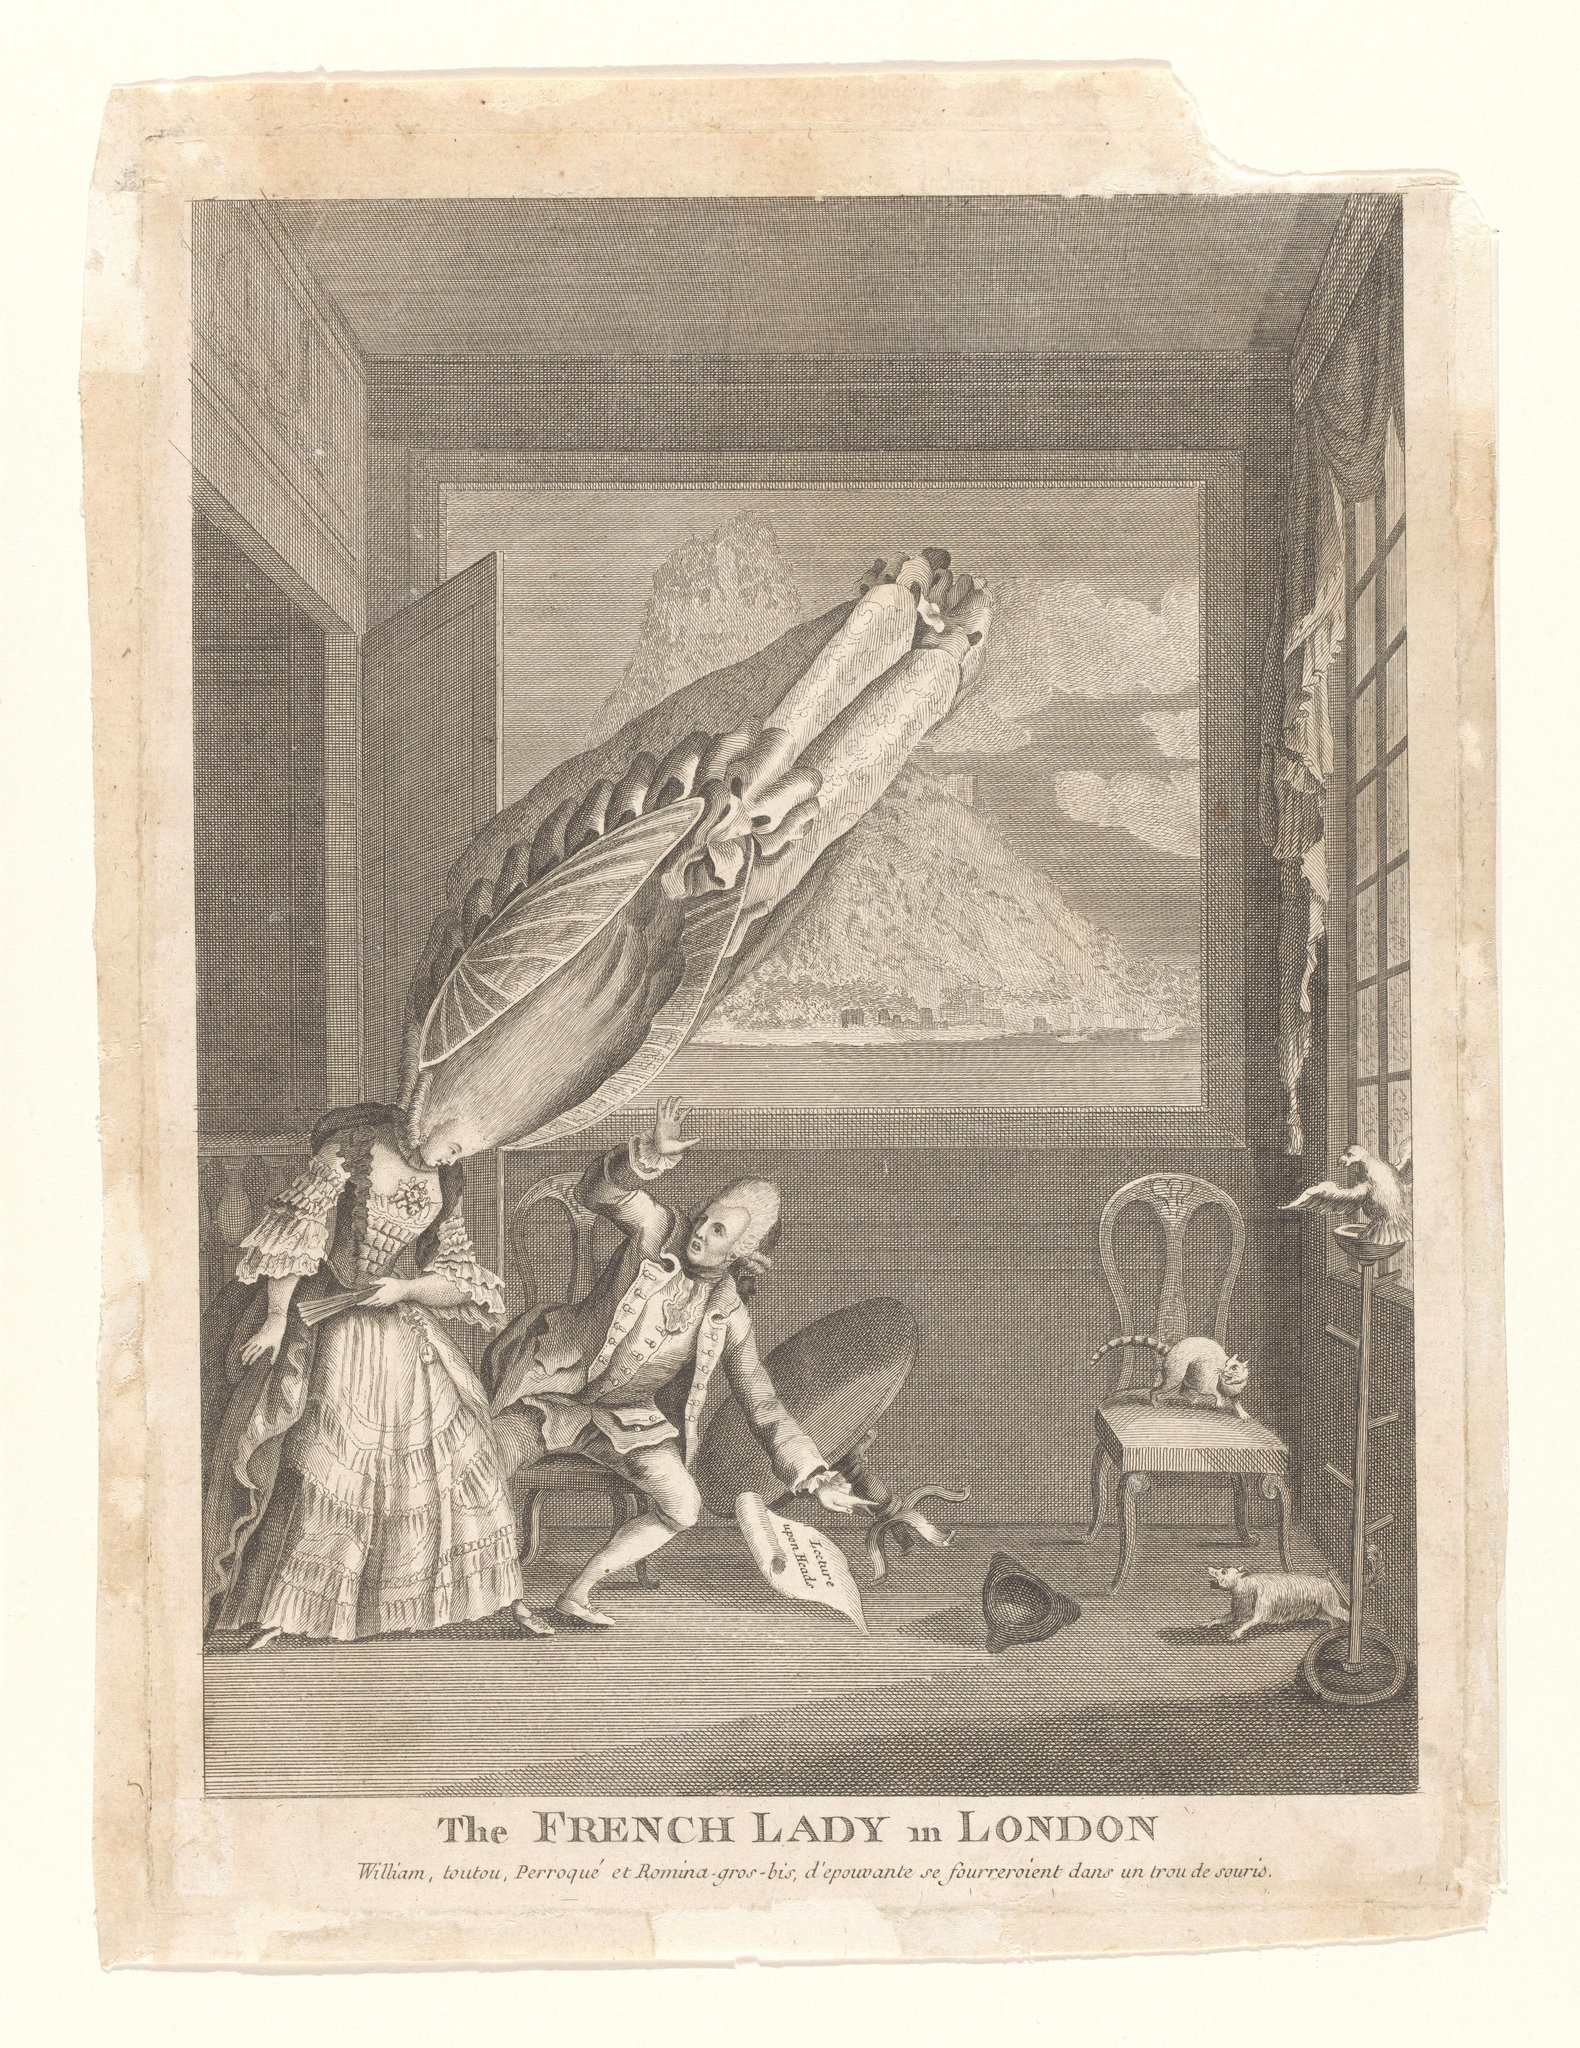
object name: print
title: The French Lady in London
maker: Anonymous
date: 1750-1799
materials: ink, paper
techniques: engraving, etching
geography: paris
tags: wig - aa - ~ women, styles of hairdress - aa - ~ women, fashion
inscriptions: collector's mark: Lugt 2228, collector's mark: Lugt 2760